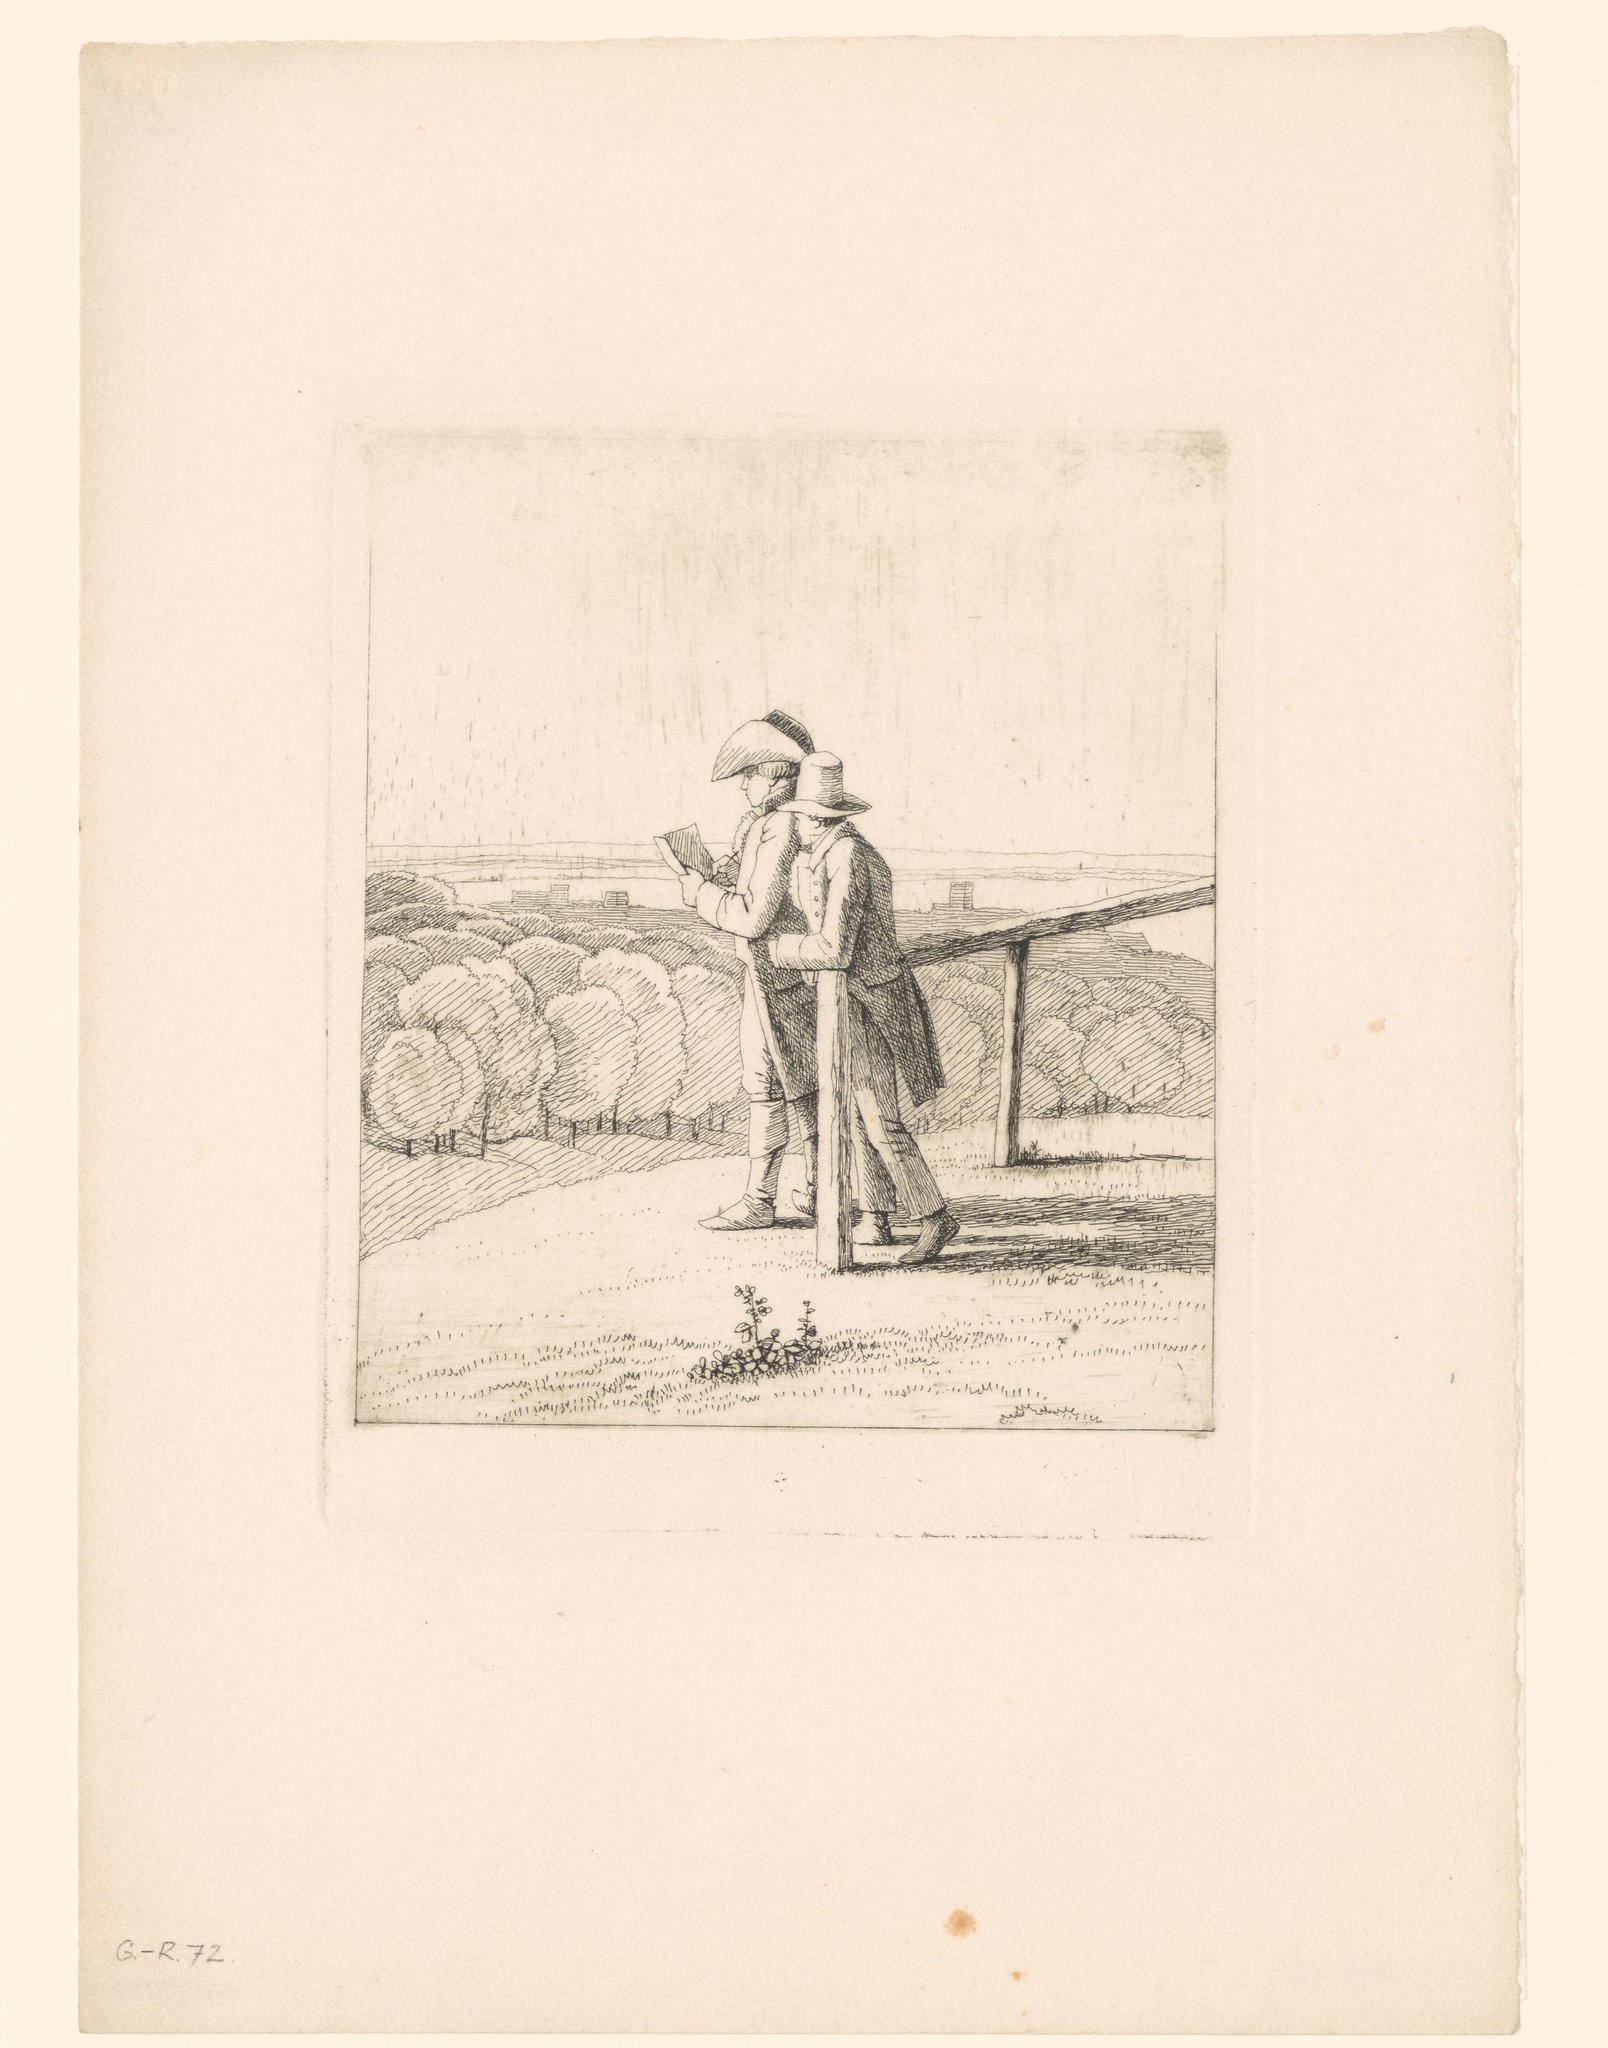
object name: print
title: Der Zeichner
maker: wilhelm alexander wolfgang von kobell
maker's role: print maker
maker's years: 1766-1855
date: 1846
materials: paper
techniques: etching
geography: germany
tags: draughtsman at work - cc - out of doors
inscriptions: collector's mark: Lugt 2760, collector's mark: Lugt 2228